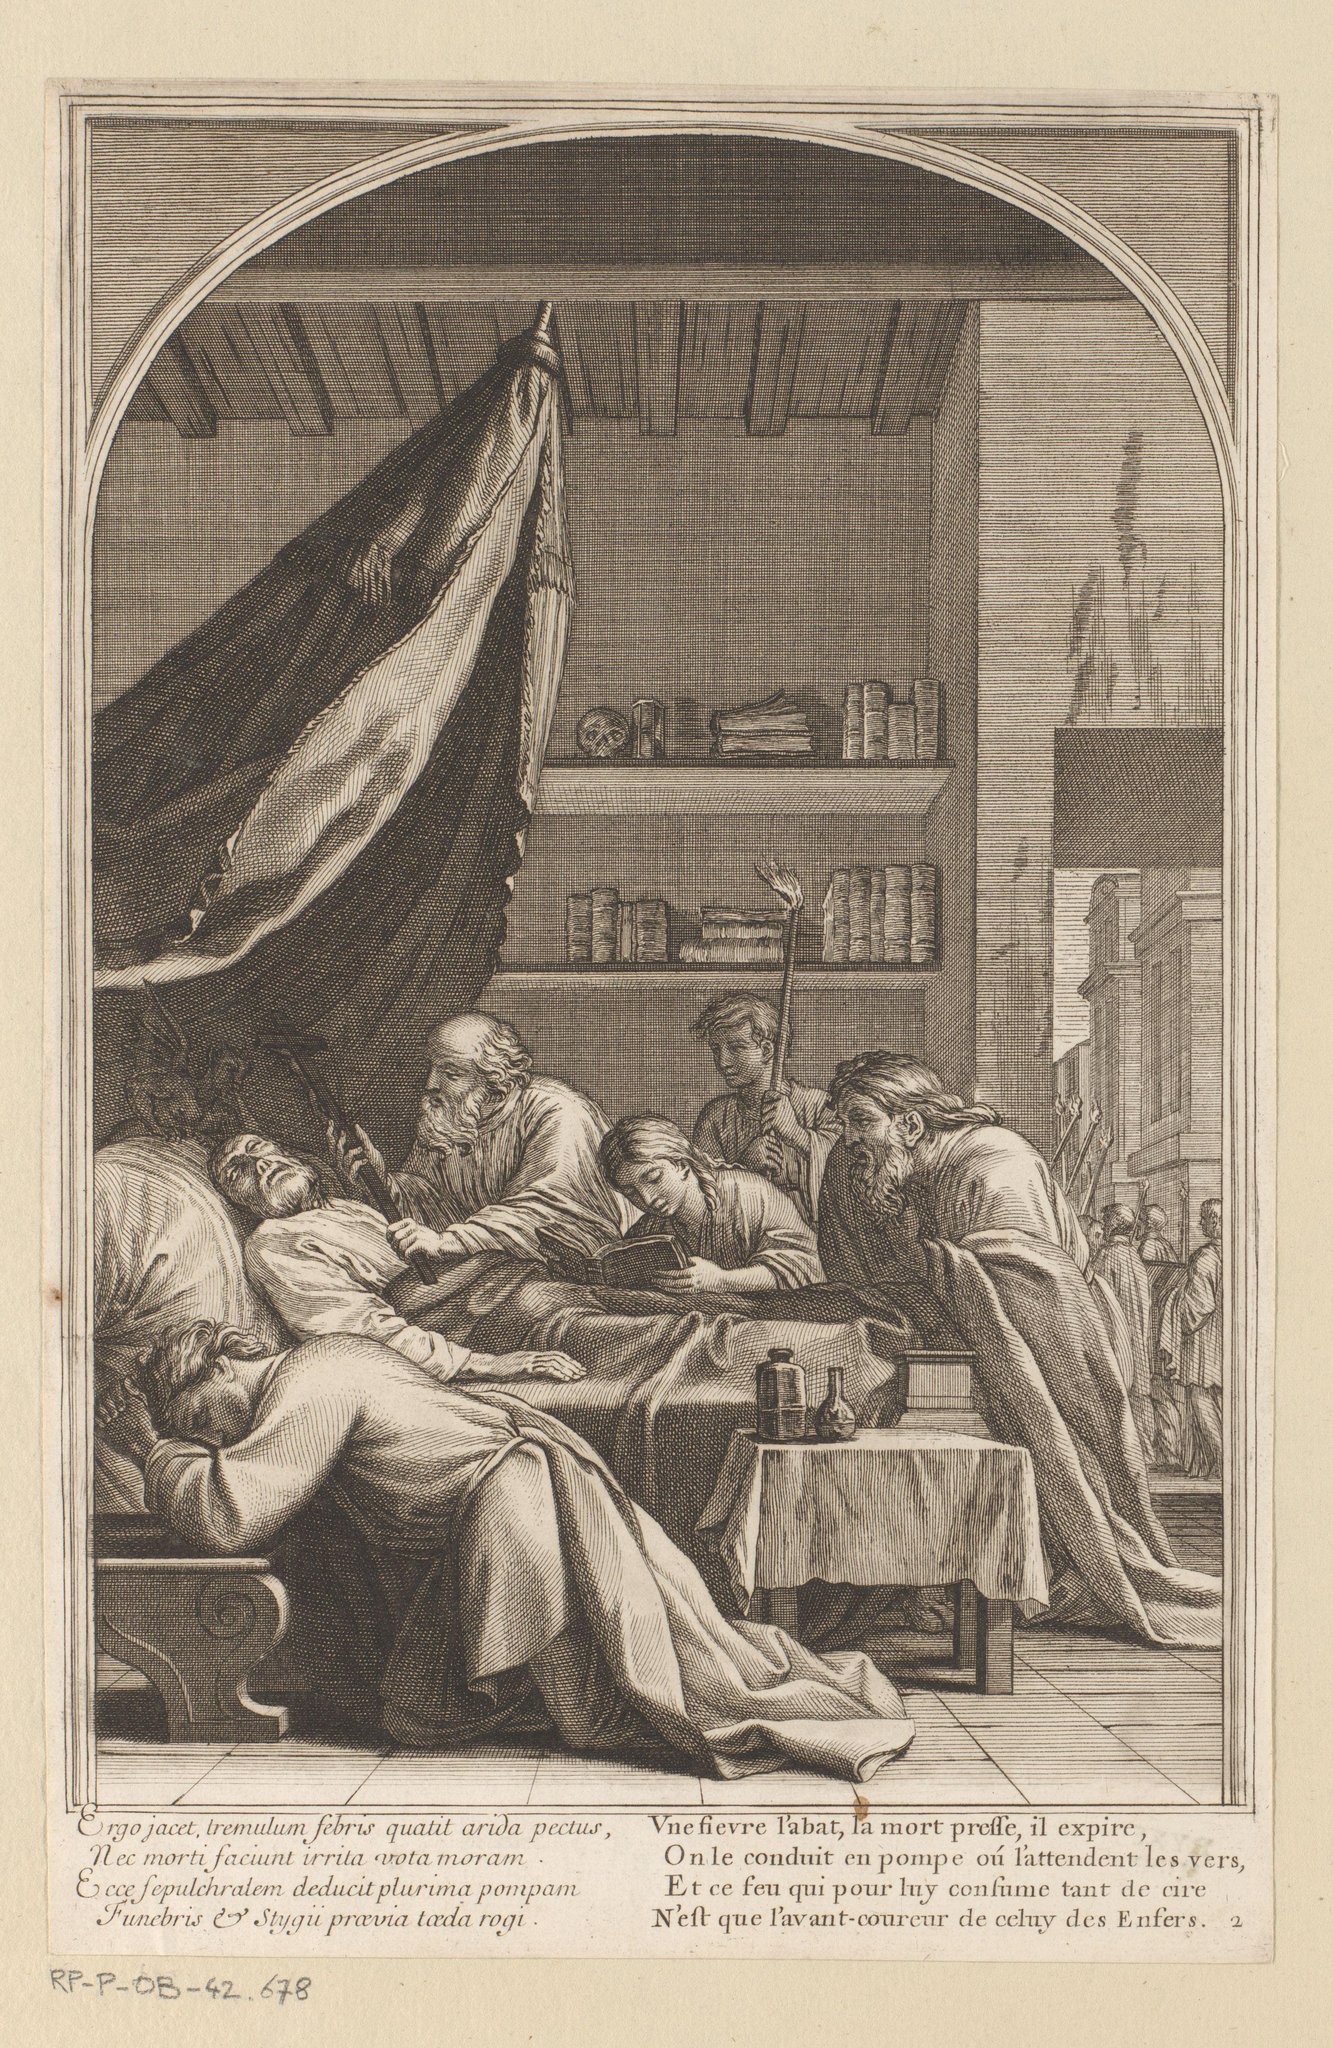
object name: print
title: La vie de St. Bruno (...)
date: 1623-1676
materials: paper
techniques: engraving, etching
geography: paris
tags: the founder of the order of the carthusians, bruno; possible attributes: cross, finger at lips, lily, mitre at his feet, olive-branch, ray of light, skull, (seven) star(s), the death of raymond diocrès: on his deathbed the tutor of st. bruno sees his own condemnation; young bruno is converted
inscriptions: collector's mark: Lugt 2165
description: Maakt deel uit van een serie met 24 prenten (inclusief twee titelprenten), naar schilderijen door Lesueur vervaardigd tussen 1645-1648 voor de Chartreuse de Paris. De serie is getiteld: La vie de St. Bruno fondateur de l'Ordre des Chartreux peinte au cloistre de la Chartreuse de Paris par Eustache Le Sueur.